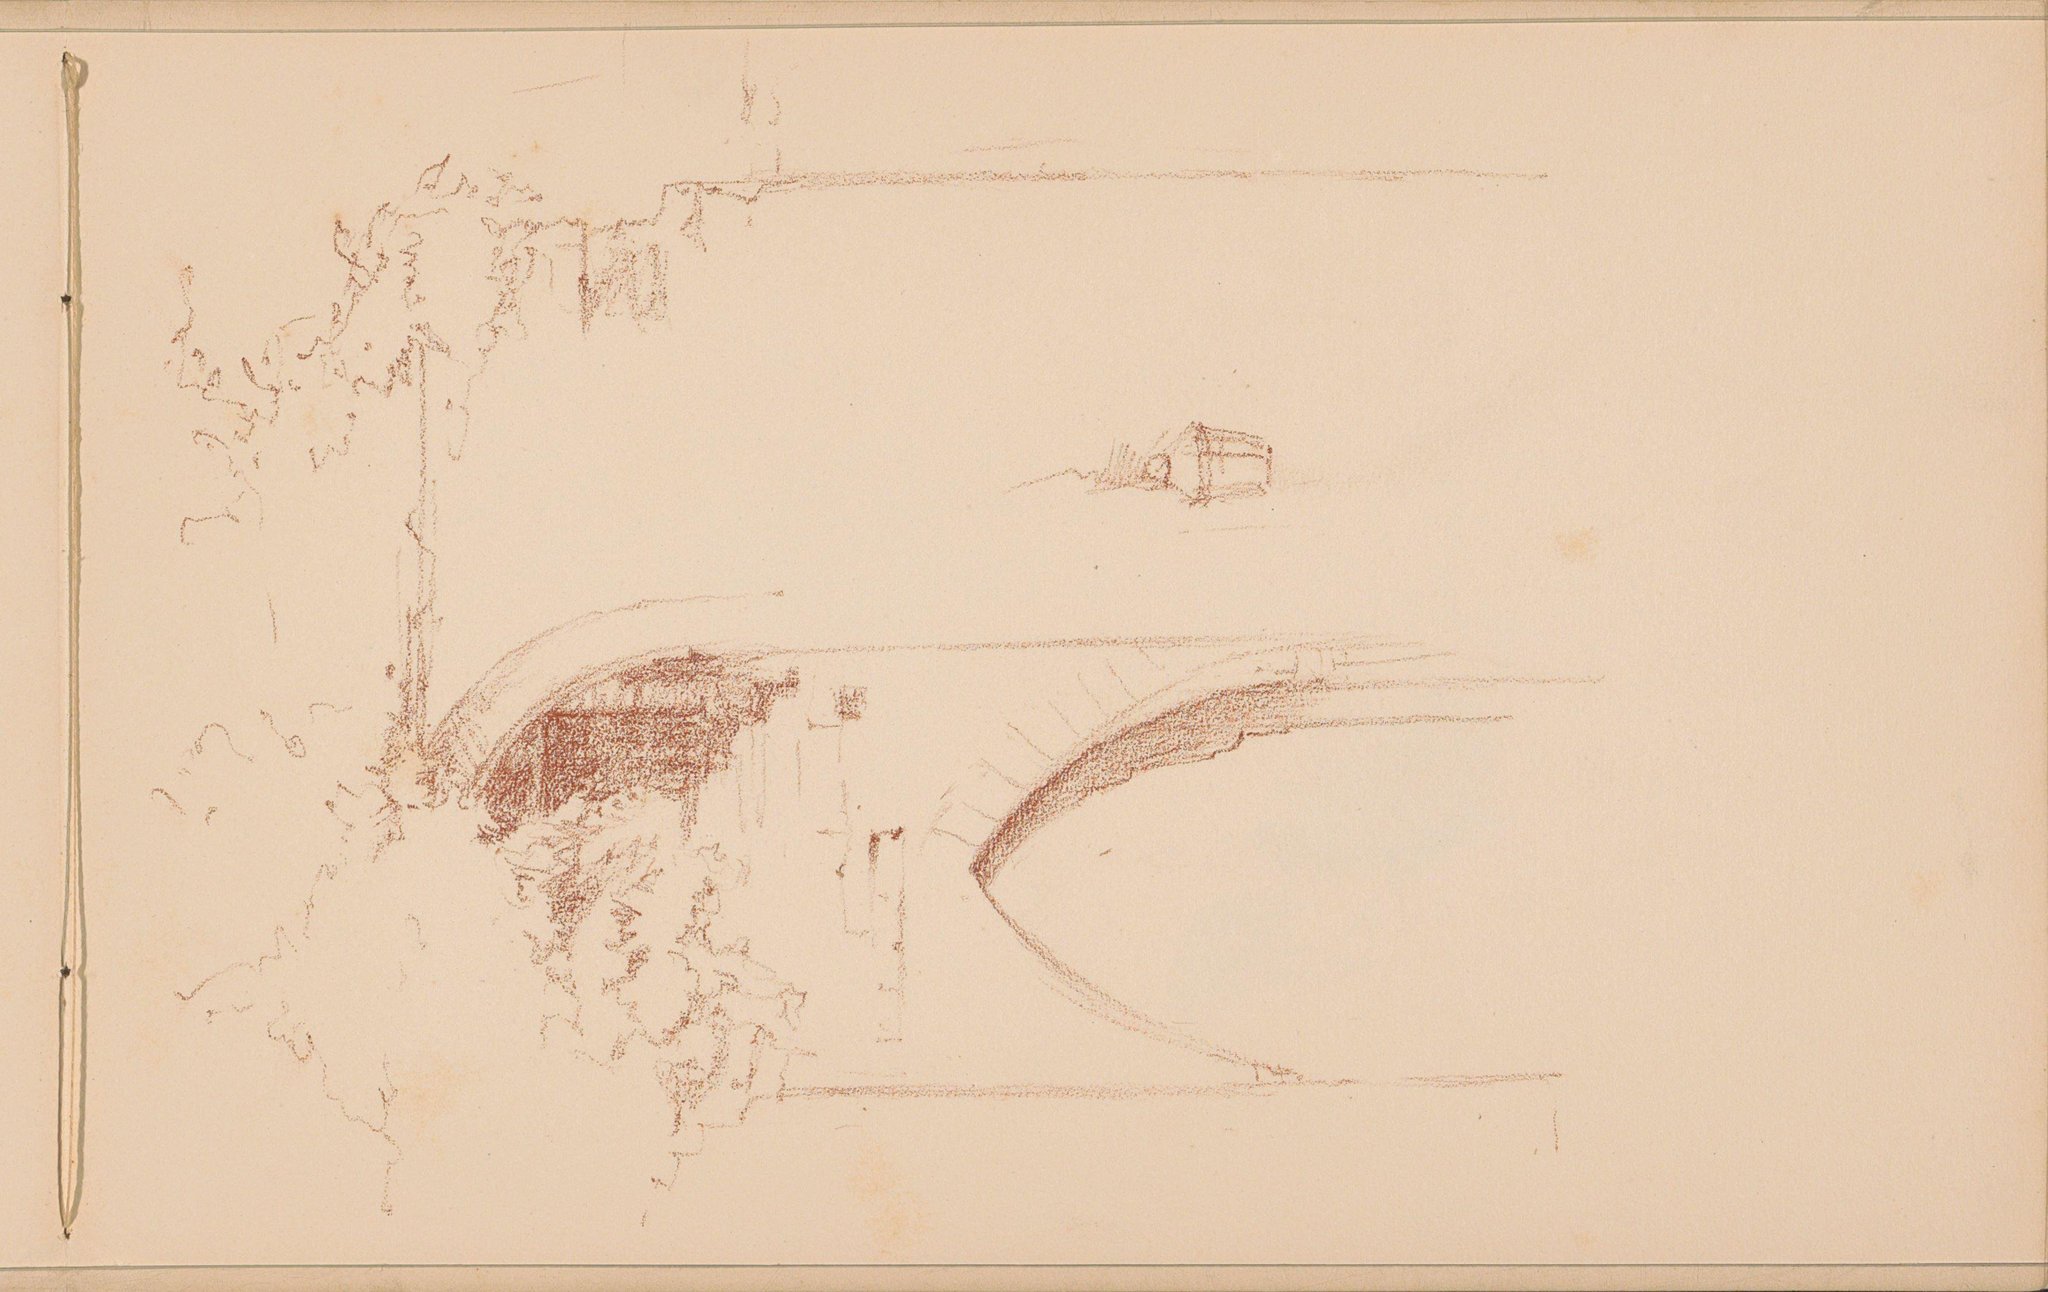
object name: sketchbook leaf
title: Stenen poort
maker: a.a.l. de grammont-hubrecht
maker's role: draughtsman, painter, print maker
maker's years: 1855-1913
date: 1865-1913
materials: chalk, paper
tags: gate, entrance, lantern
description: Naast de met planten begroeide poort hangt een lantaarn. Blad 16 recto uit een schetsboek met 65 bladen.